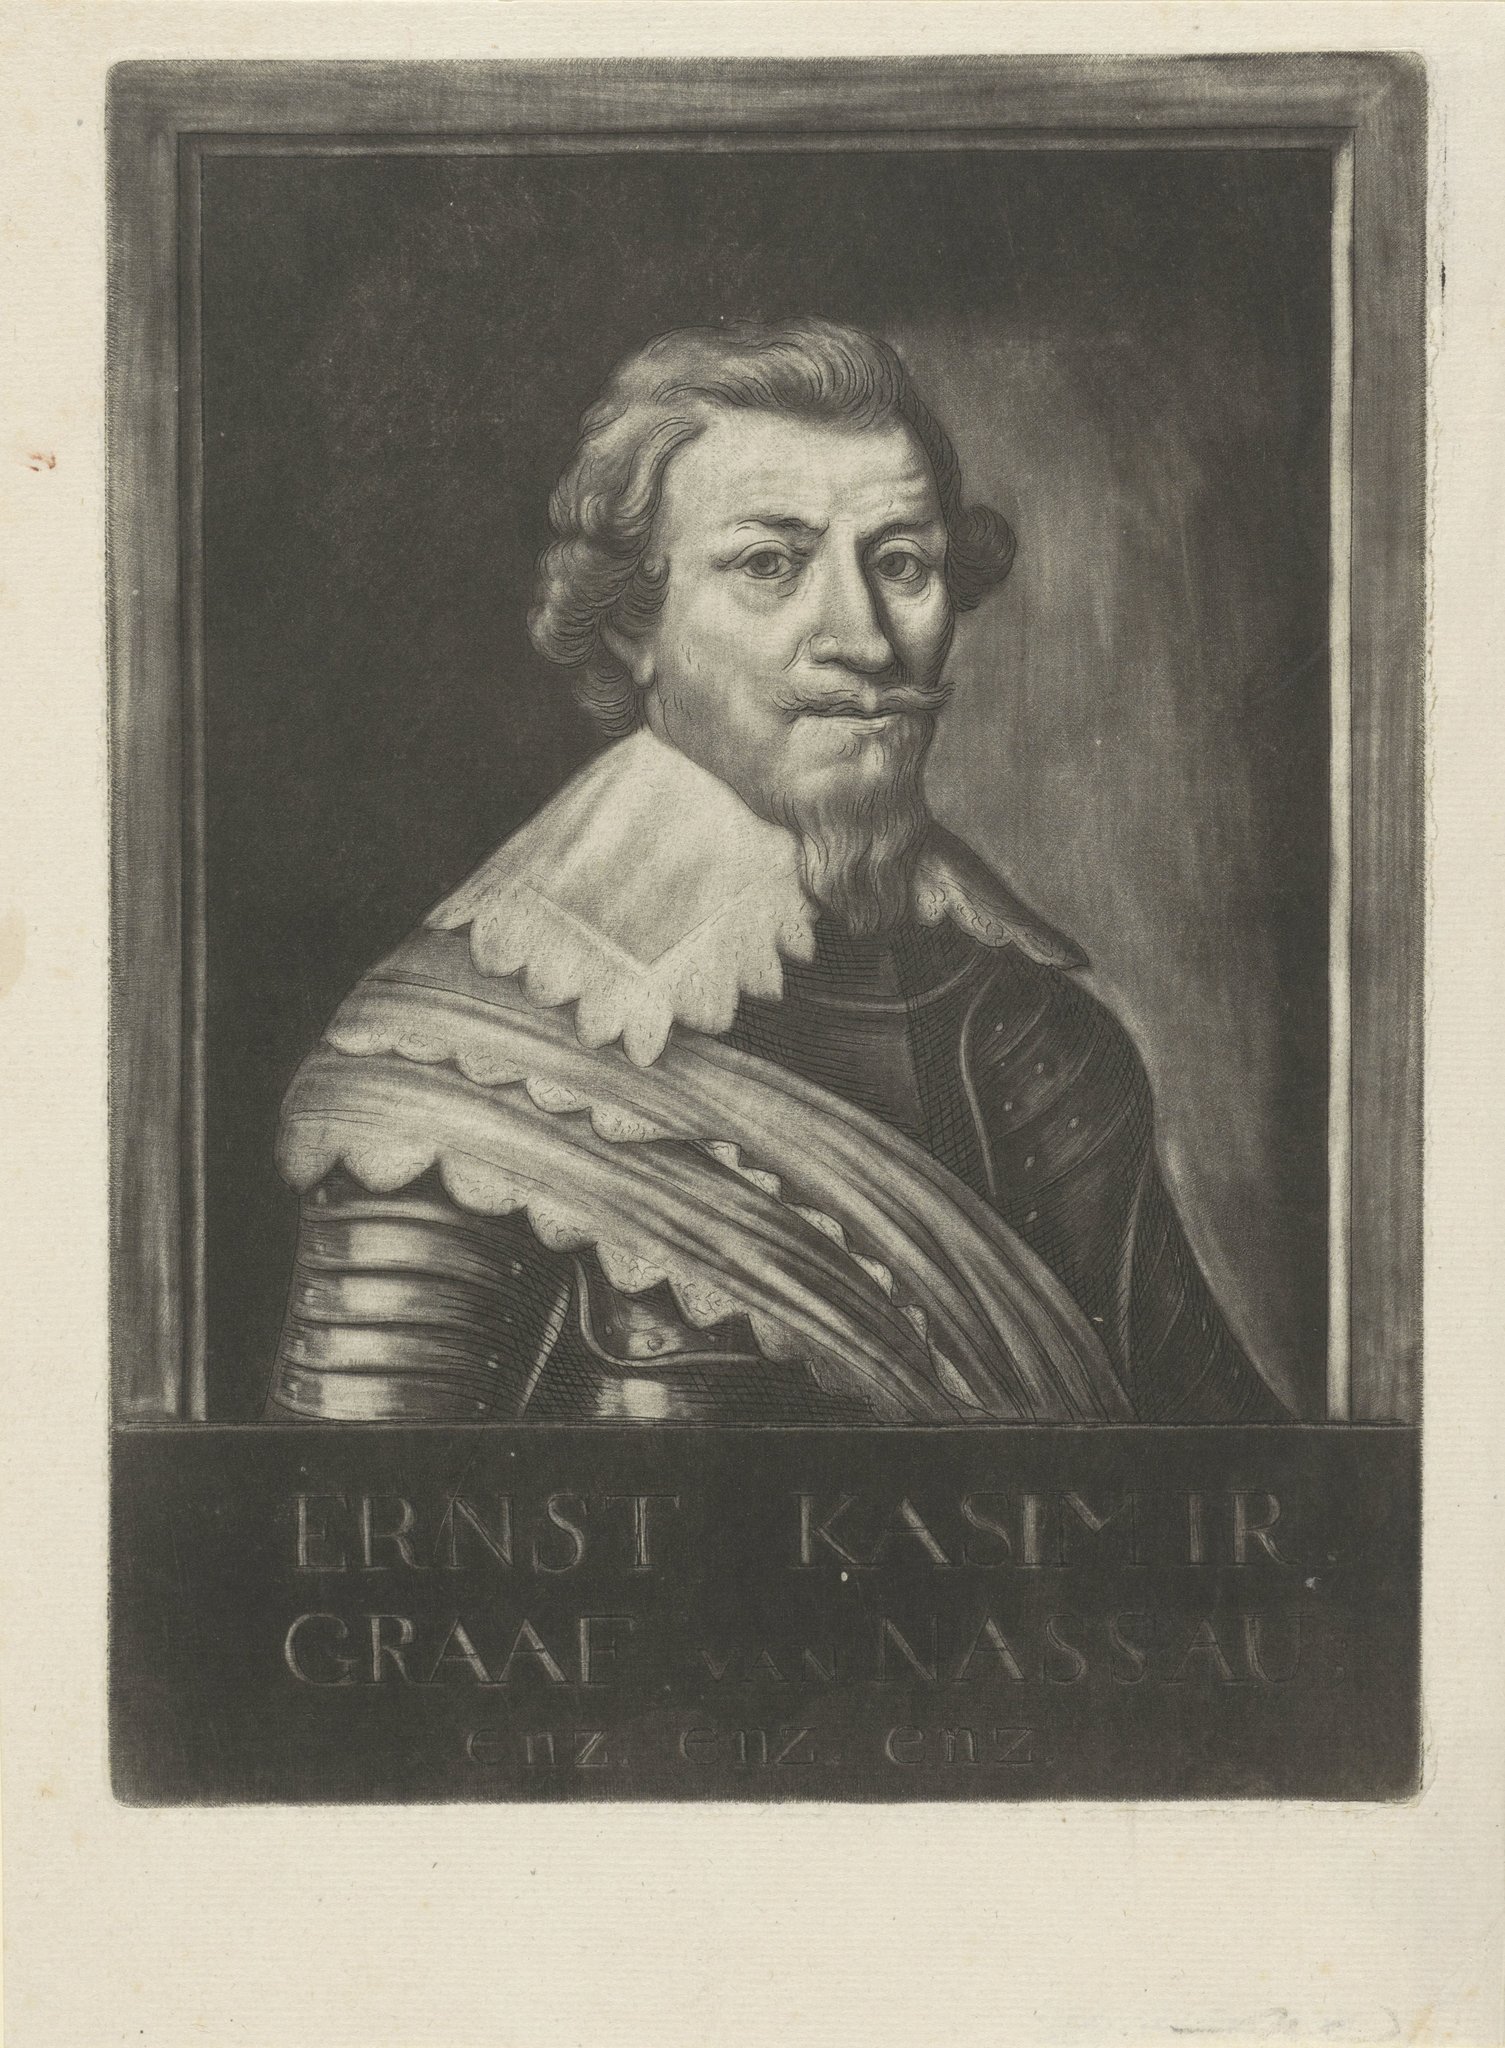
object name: print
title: Portret van Ernst Casimir, graaf van Nassau-Dietz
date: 1770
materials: paper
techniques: etching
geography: northern netherlands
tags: ernst casimir graaf van nassau-dietz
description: De hier vermelde titel verwijst naar de hoogst verkregen titel van de geportretteerde, niet per se naar de titel die de geportretteerde op deze voorstelling draagt. Prent uit: Bosch, Johannes van den. De heeren stadhouderen van Vriesland, zedert den jare acht-hondert, volgens hoogst derzelver successie kortelyk beschreven. Leeuwarden: Abraham Ferwerda en Gerrit Tresling, 1770.